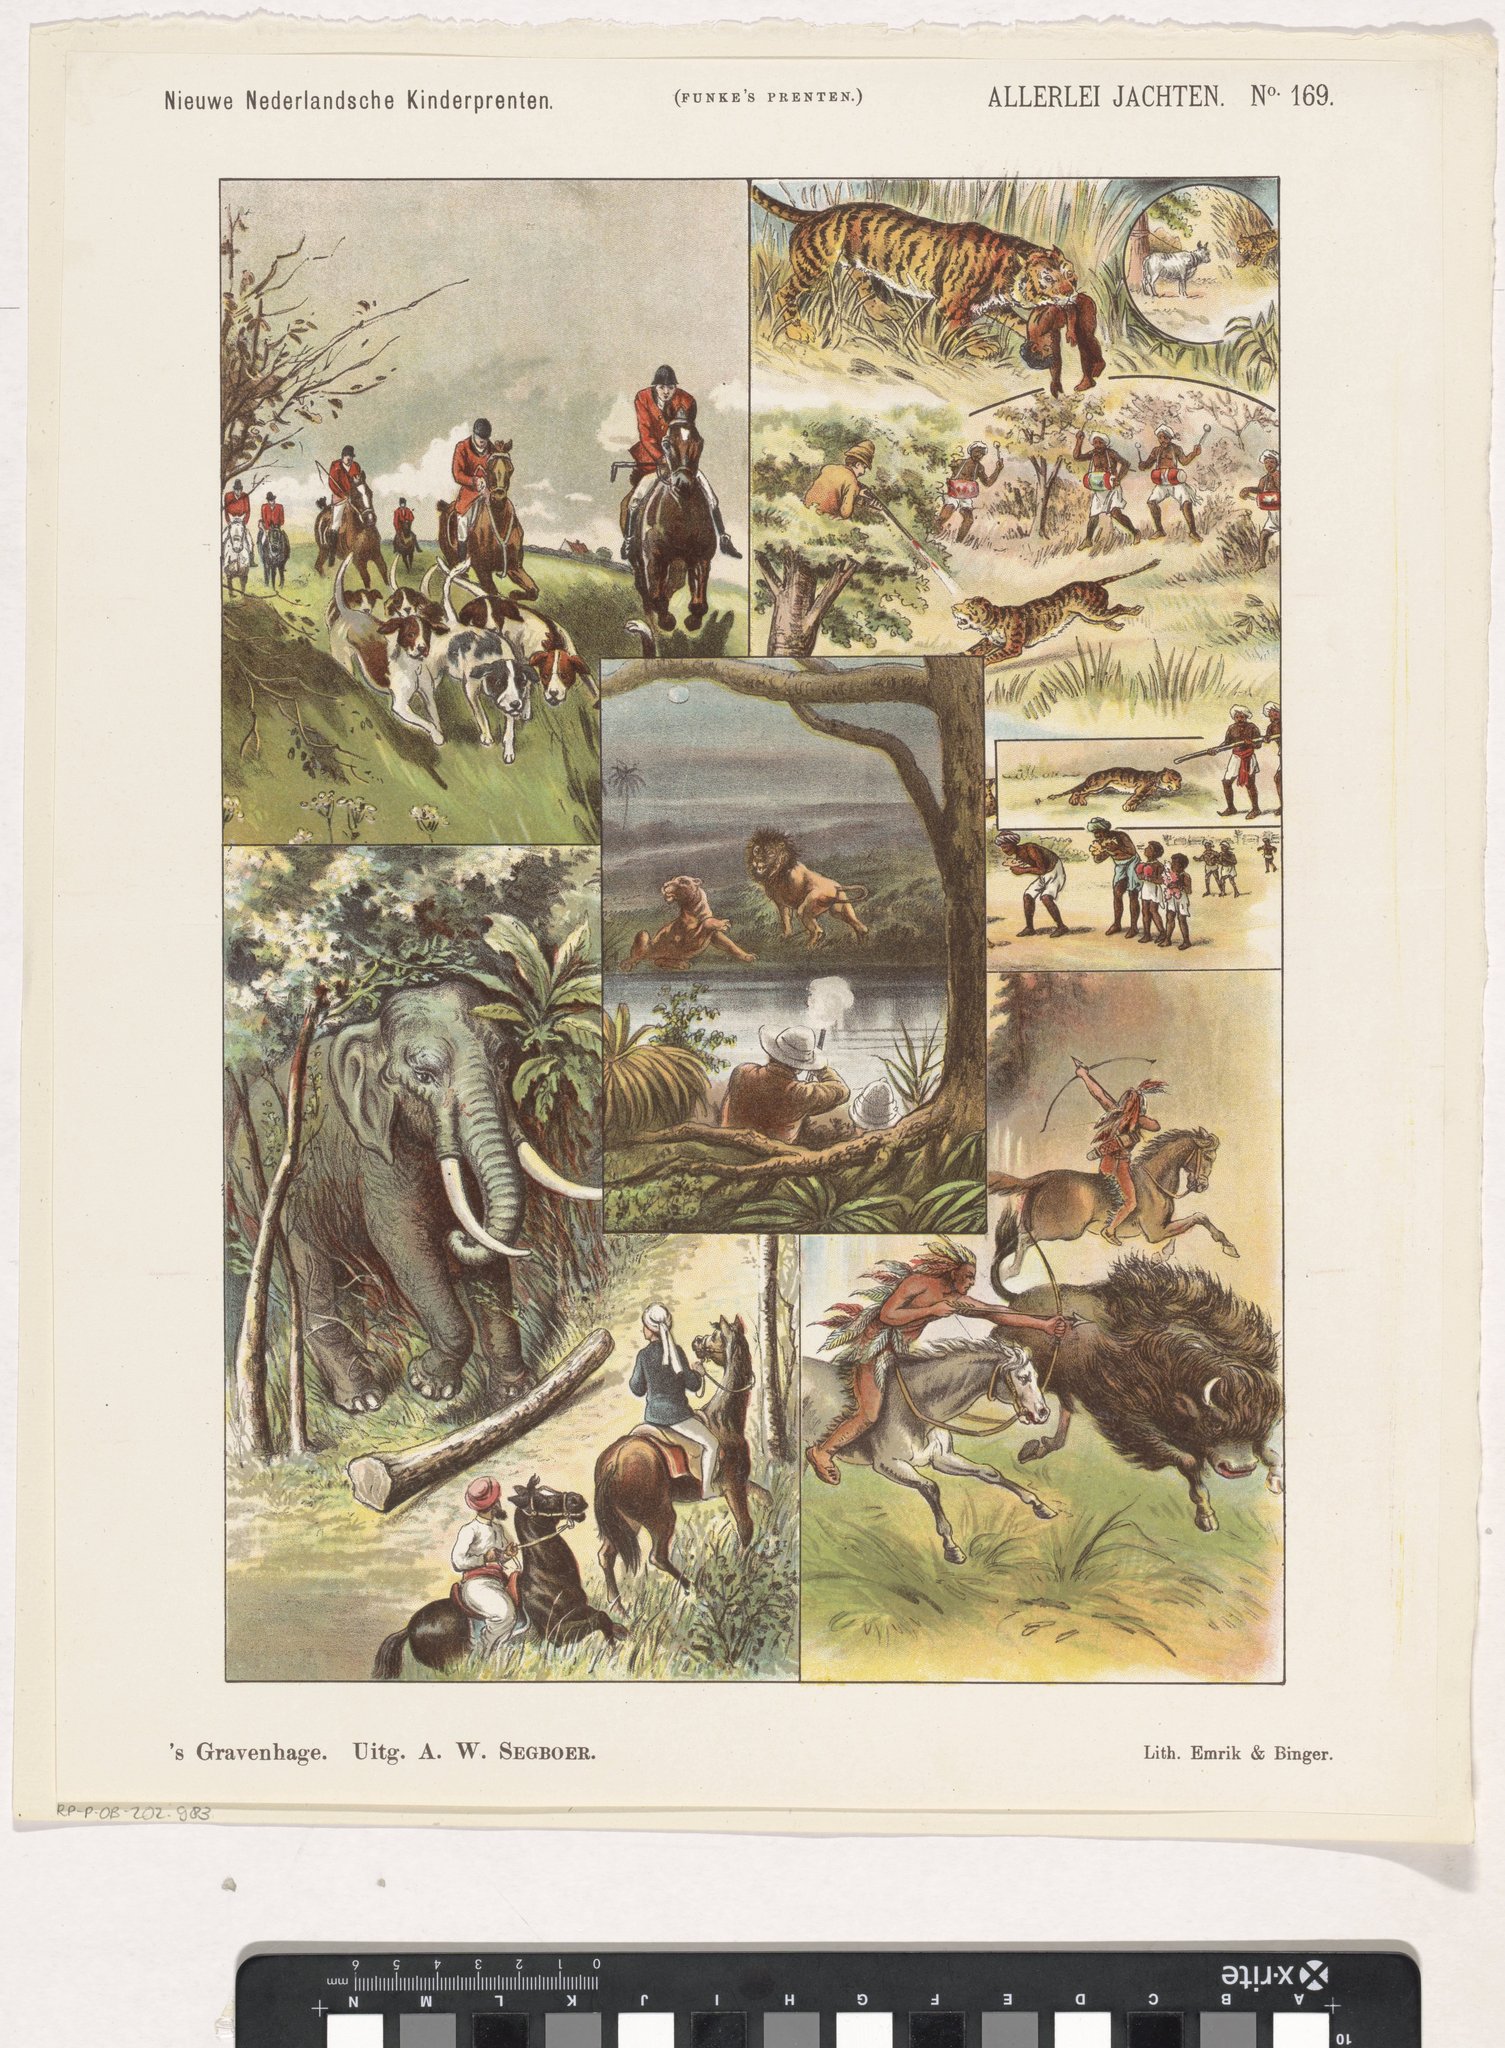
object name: popular print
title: Nieuwe Nederlandsche kinderprenten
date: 1903-1919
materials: paper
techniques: lithograph, letterpress printing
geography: haarlem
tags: hunter, hunters hunting (n.b.: in 1988-1990 this notation denoted the concept of 43c11421 'hunters resting during the hunt'), indigenous peoples of north america, fox hunting, hoofed animals: bison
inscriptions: collector's mark: Lugt 2760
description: Blad met zeven voorstellingen van jagers, waaronder jagers te paard op vossenjacht, mannen met geweren die jagen op leeuwen en oorspronkelijke Amerikanen op bizons. Genummerd rechtsboven: No. 169.